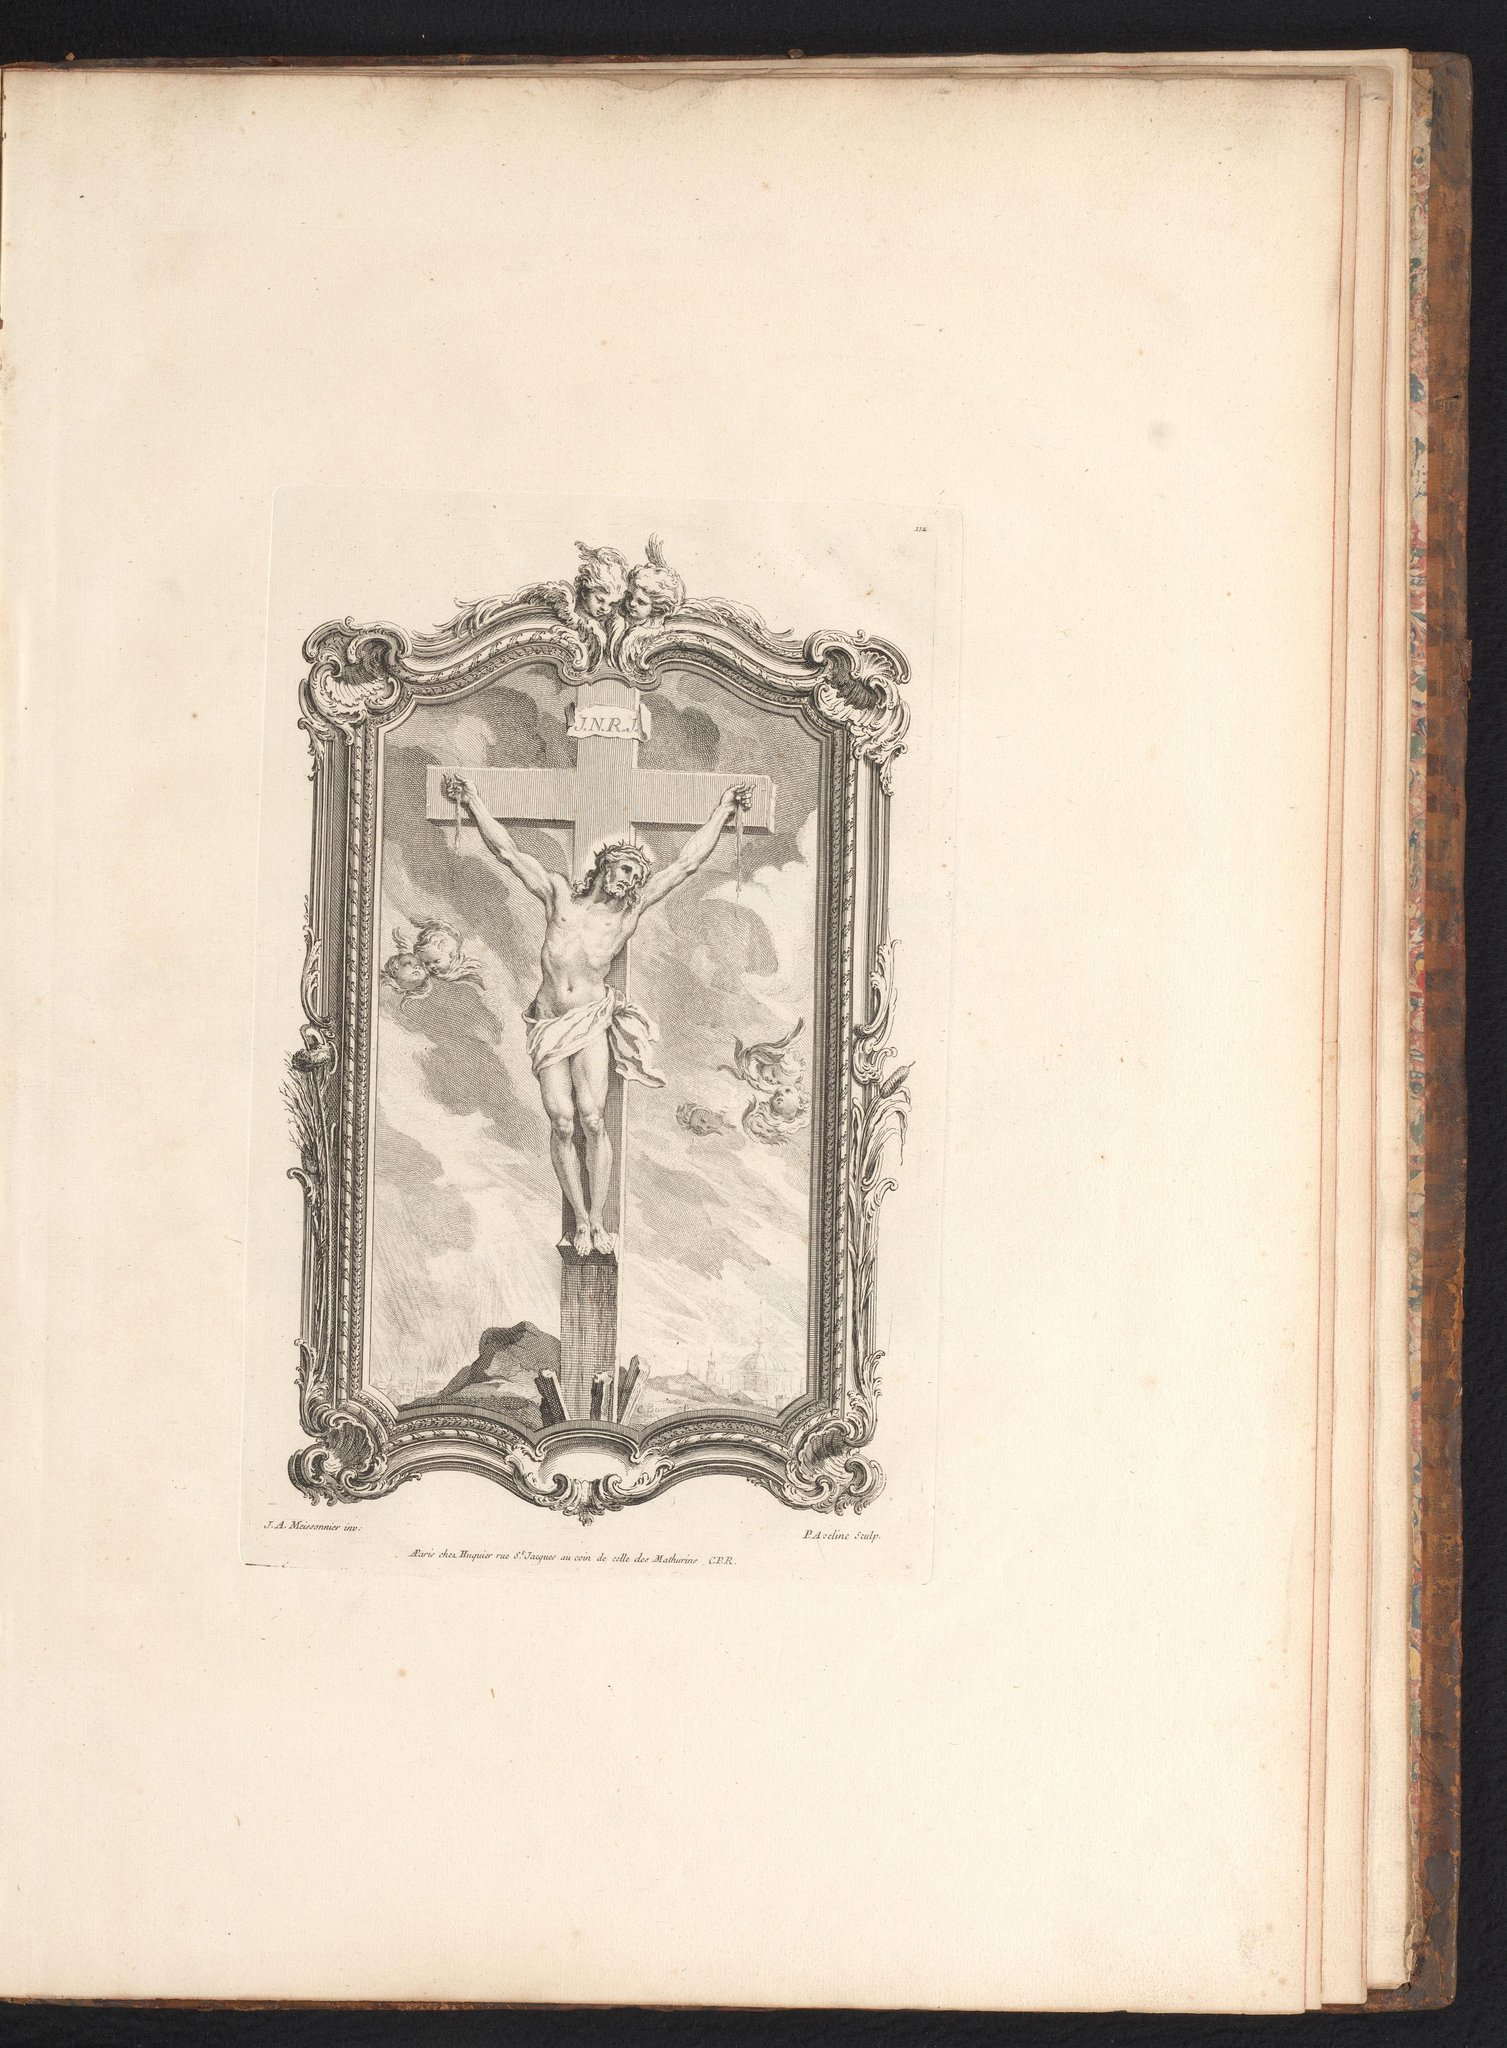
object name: album leaf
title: Christus aan het kruis, in een rocaille ornamentrand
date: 1738-1749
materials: paper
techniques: etching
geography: paris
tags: rocaille ornament, christ on the cross on golgotha (alone, without bystanders)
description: Deze prent maakt deel uit van een album.